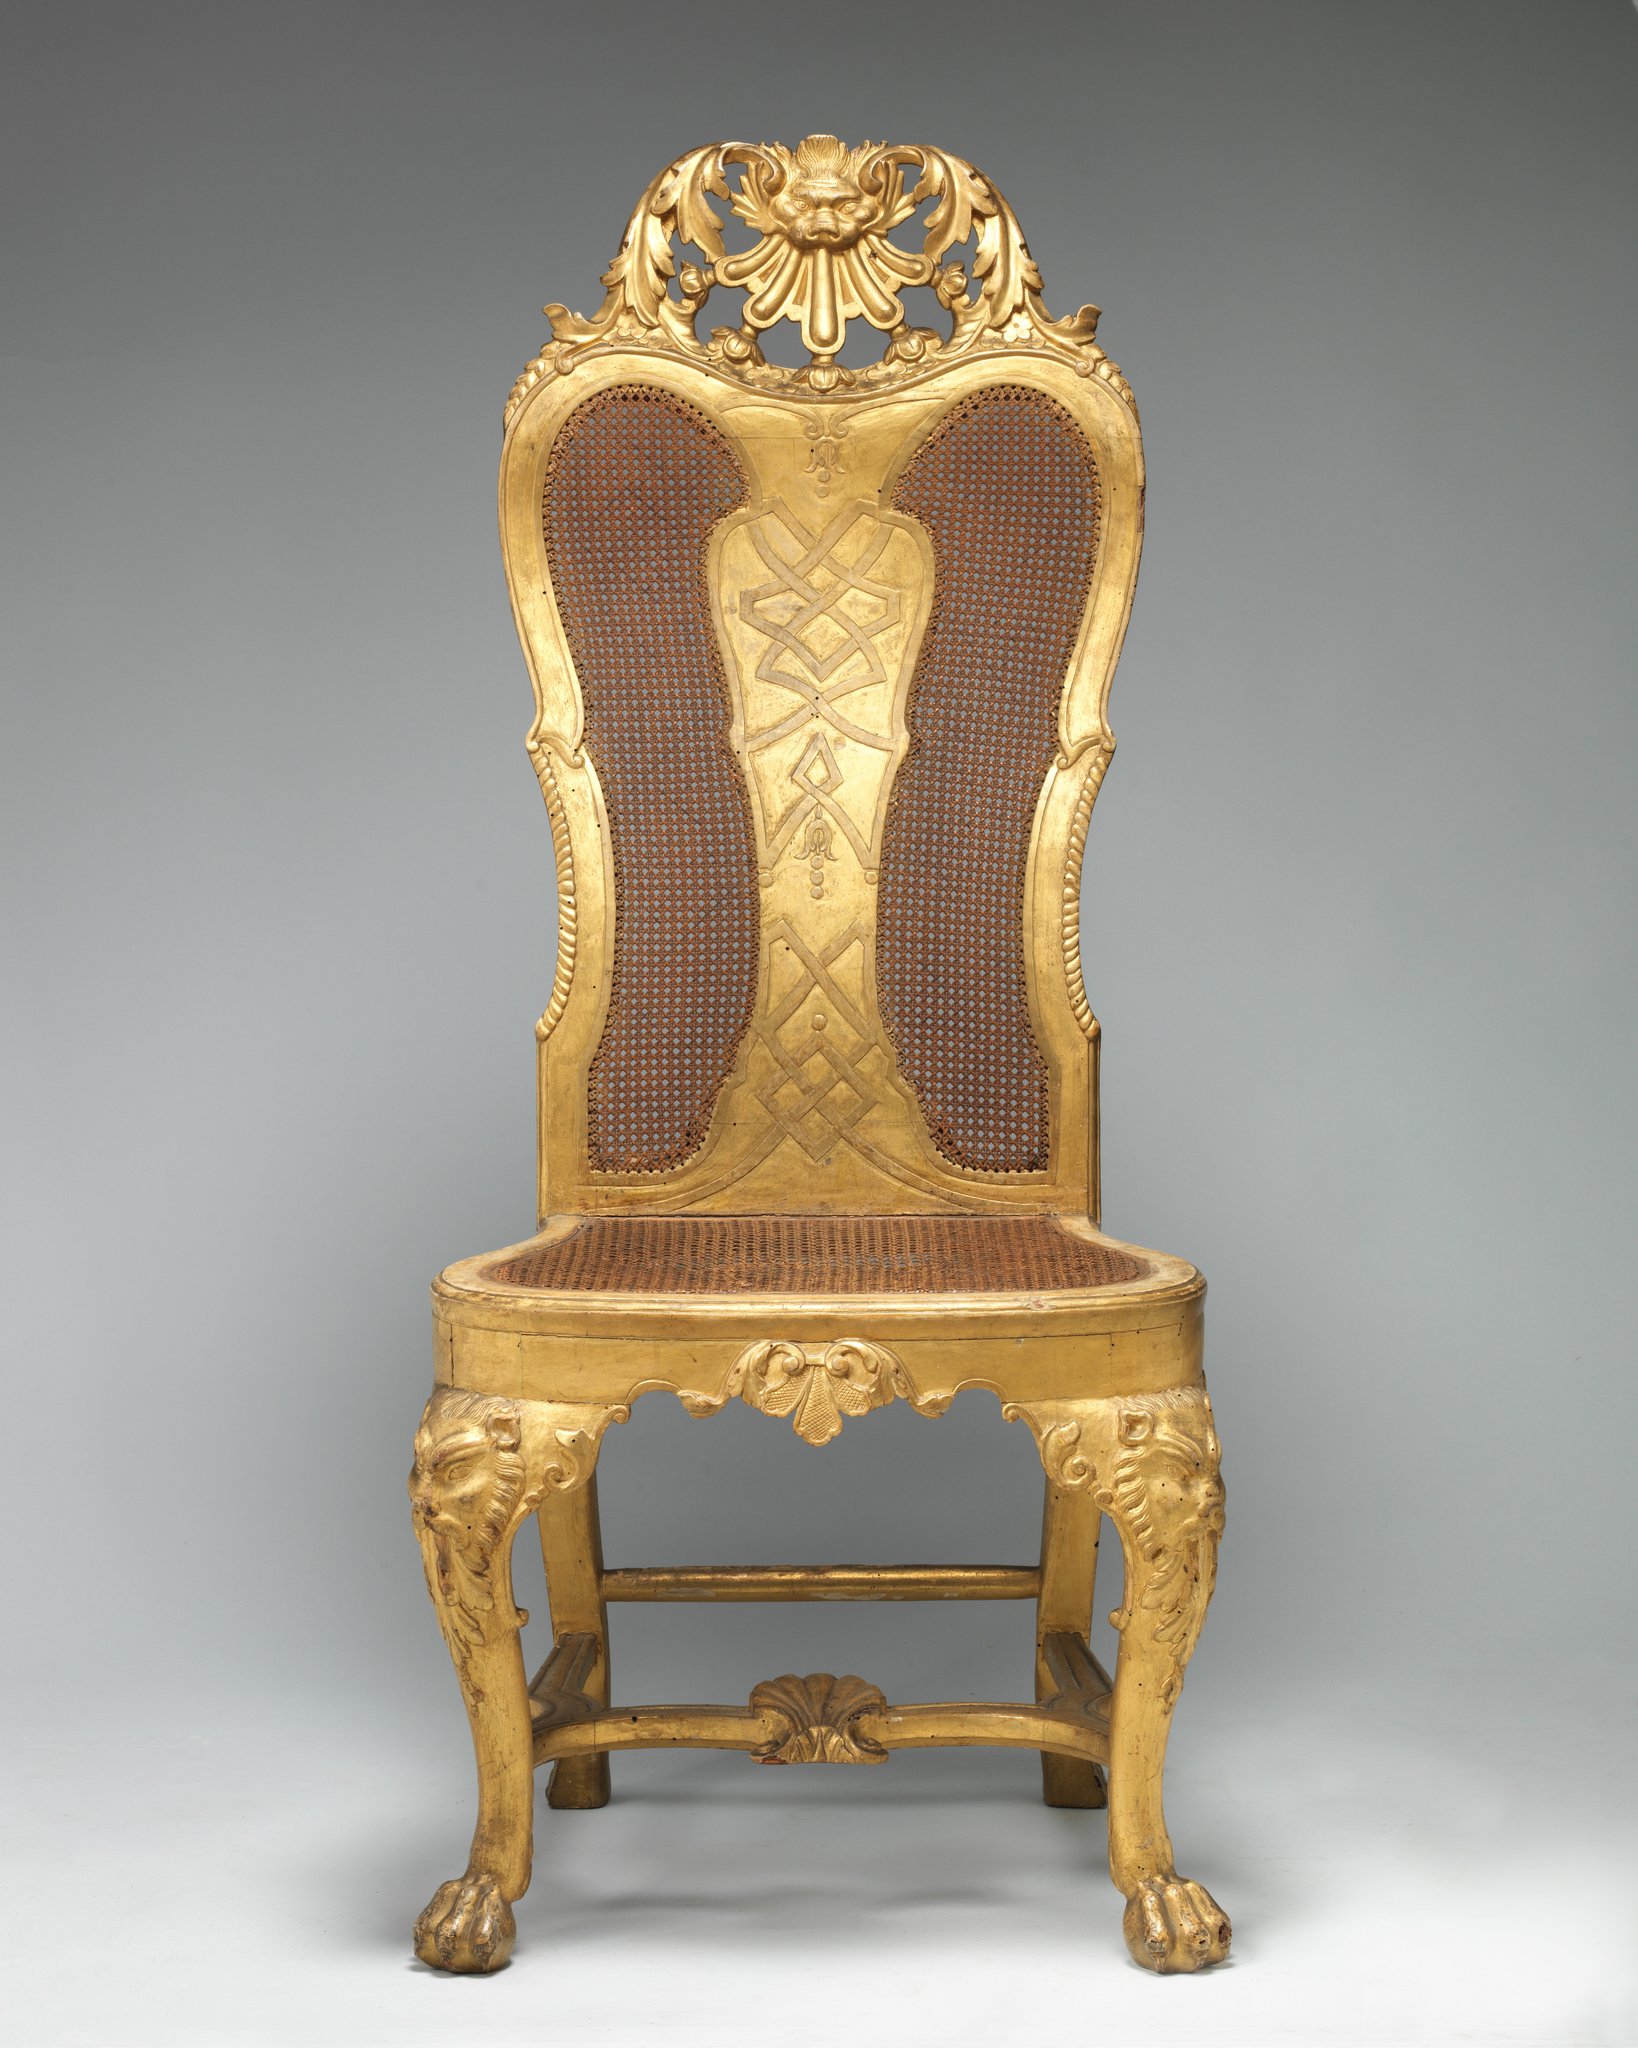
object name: side chair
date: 1720-1730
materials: gesso, gilt, wood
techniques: carving